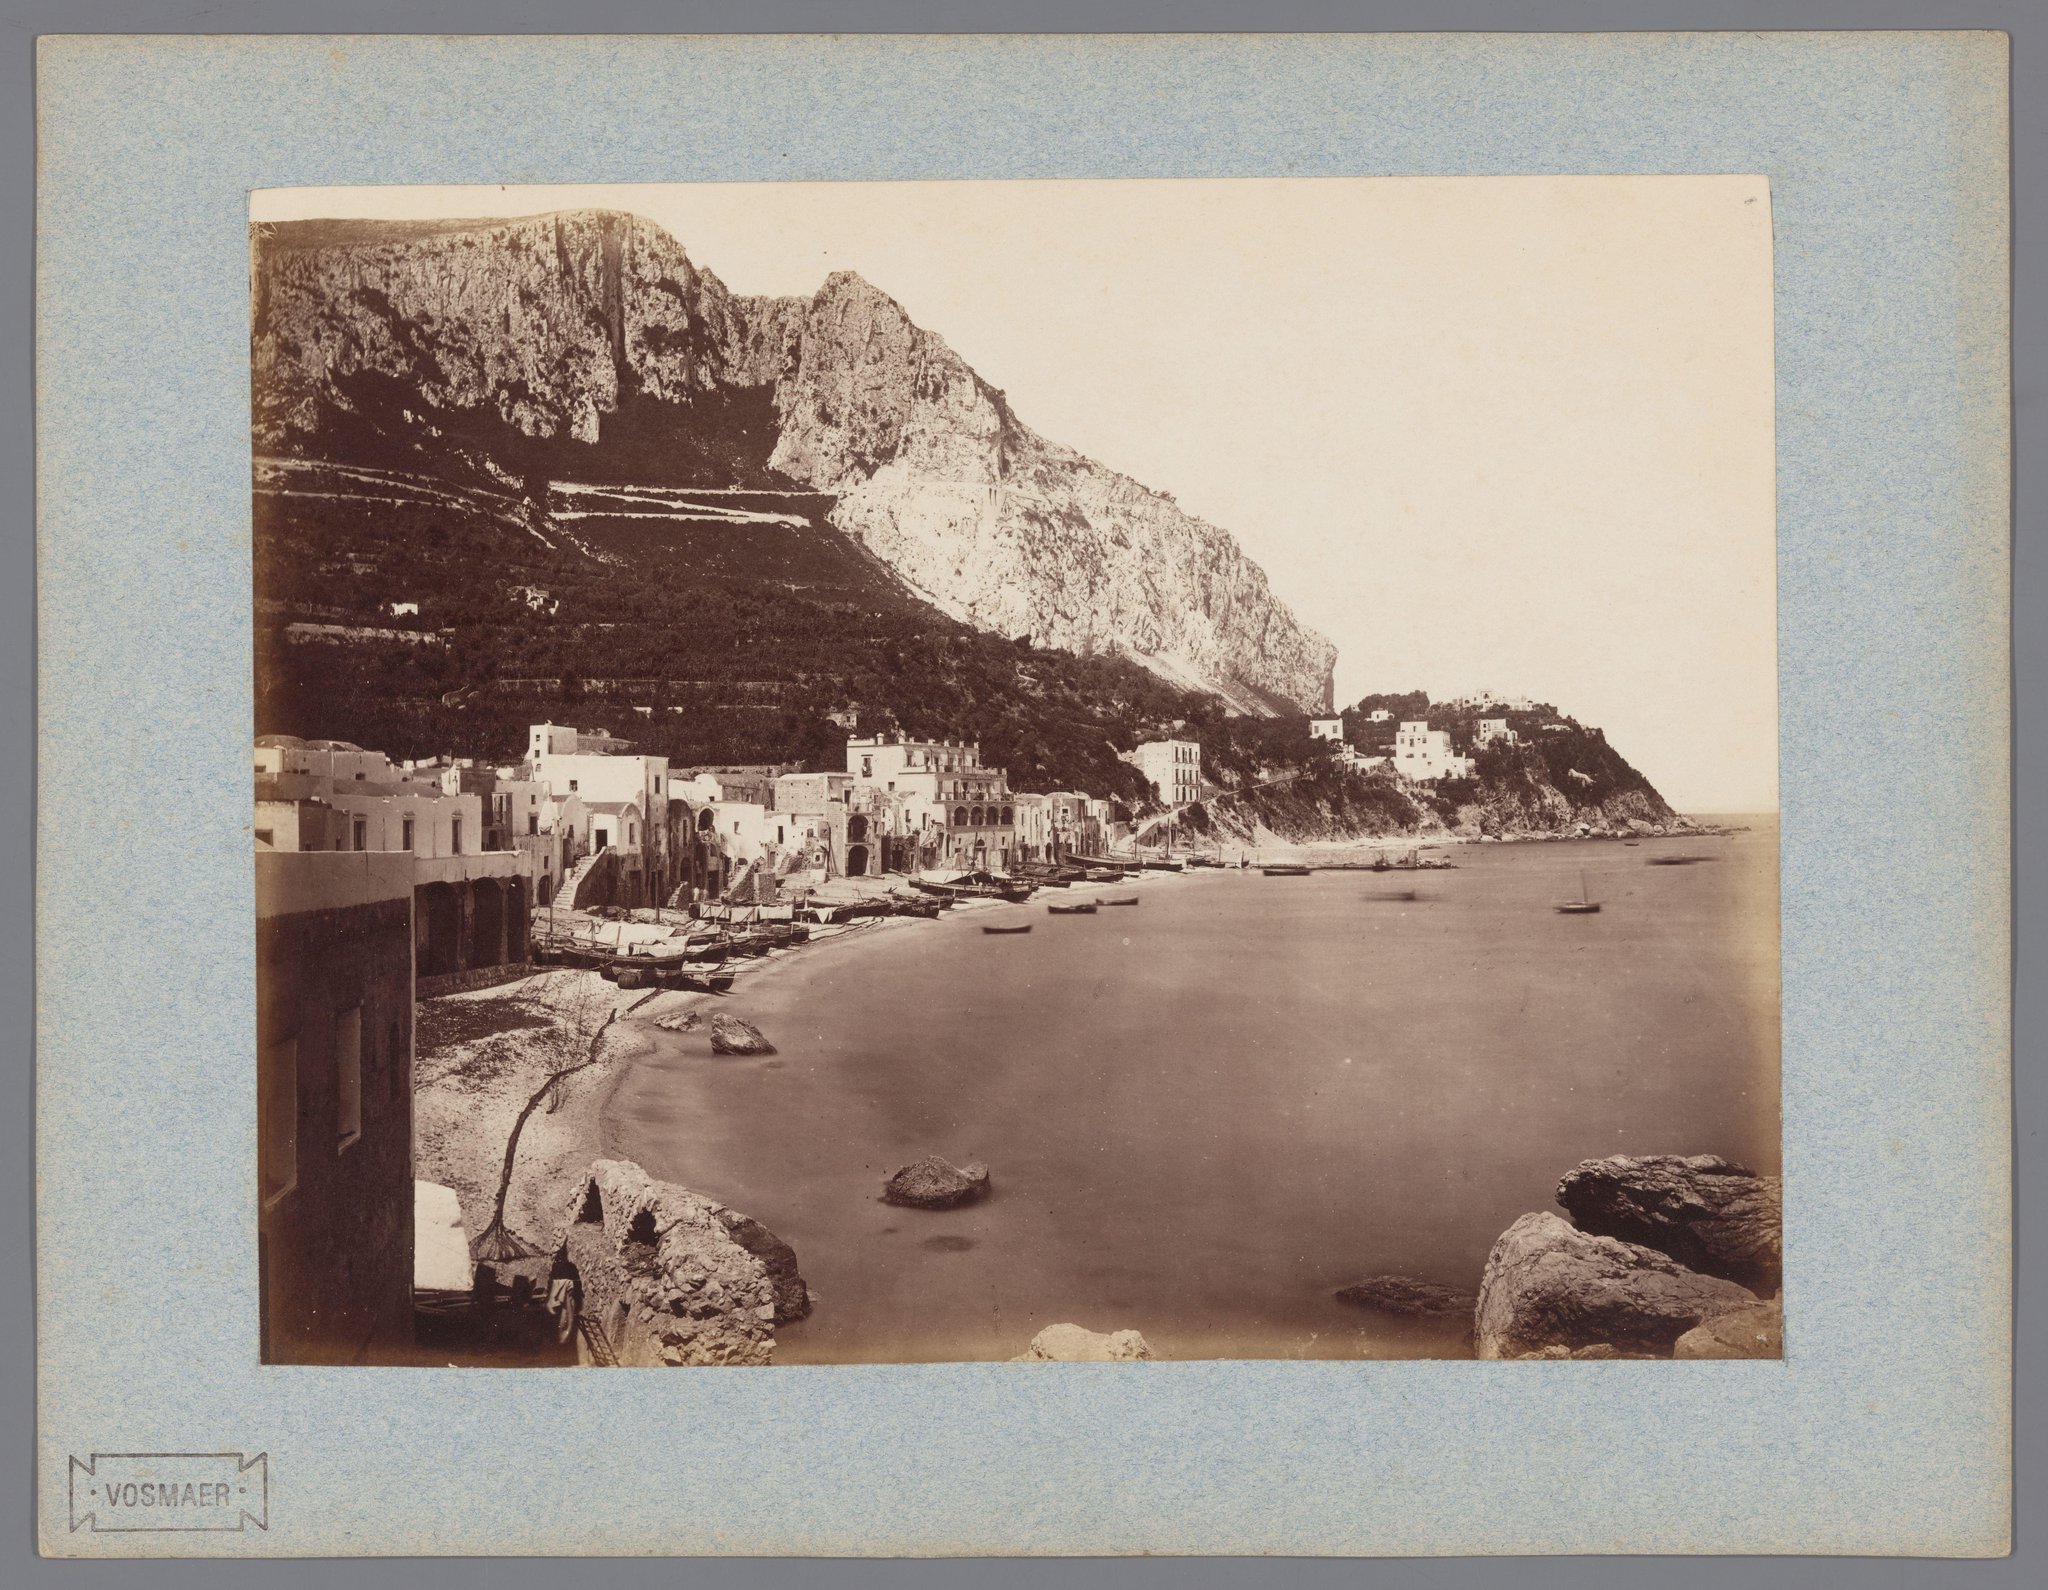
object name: photograph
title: Gezicht op Capri en de kust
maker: Anonymous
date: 1851-1900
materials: cardboard, paper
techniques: albumen print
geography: capri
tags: island, city-view in general; 'veduta', coast, mountains, capri, isola di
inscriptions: collector's mark: ‘VOSMAER’